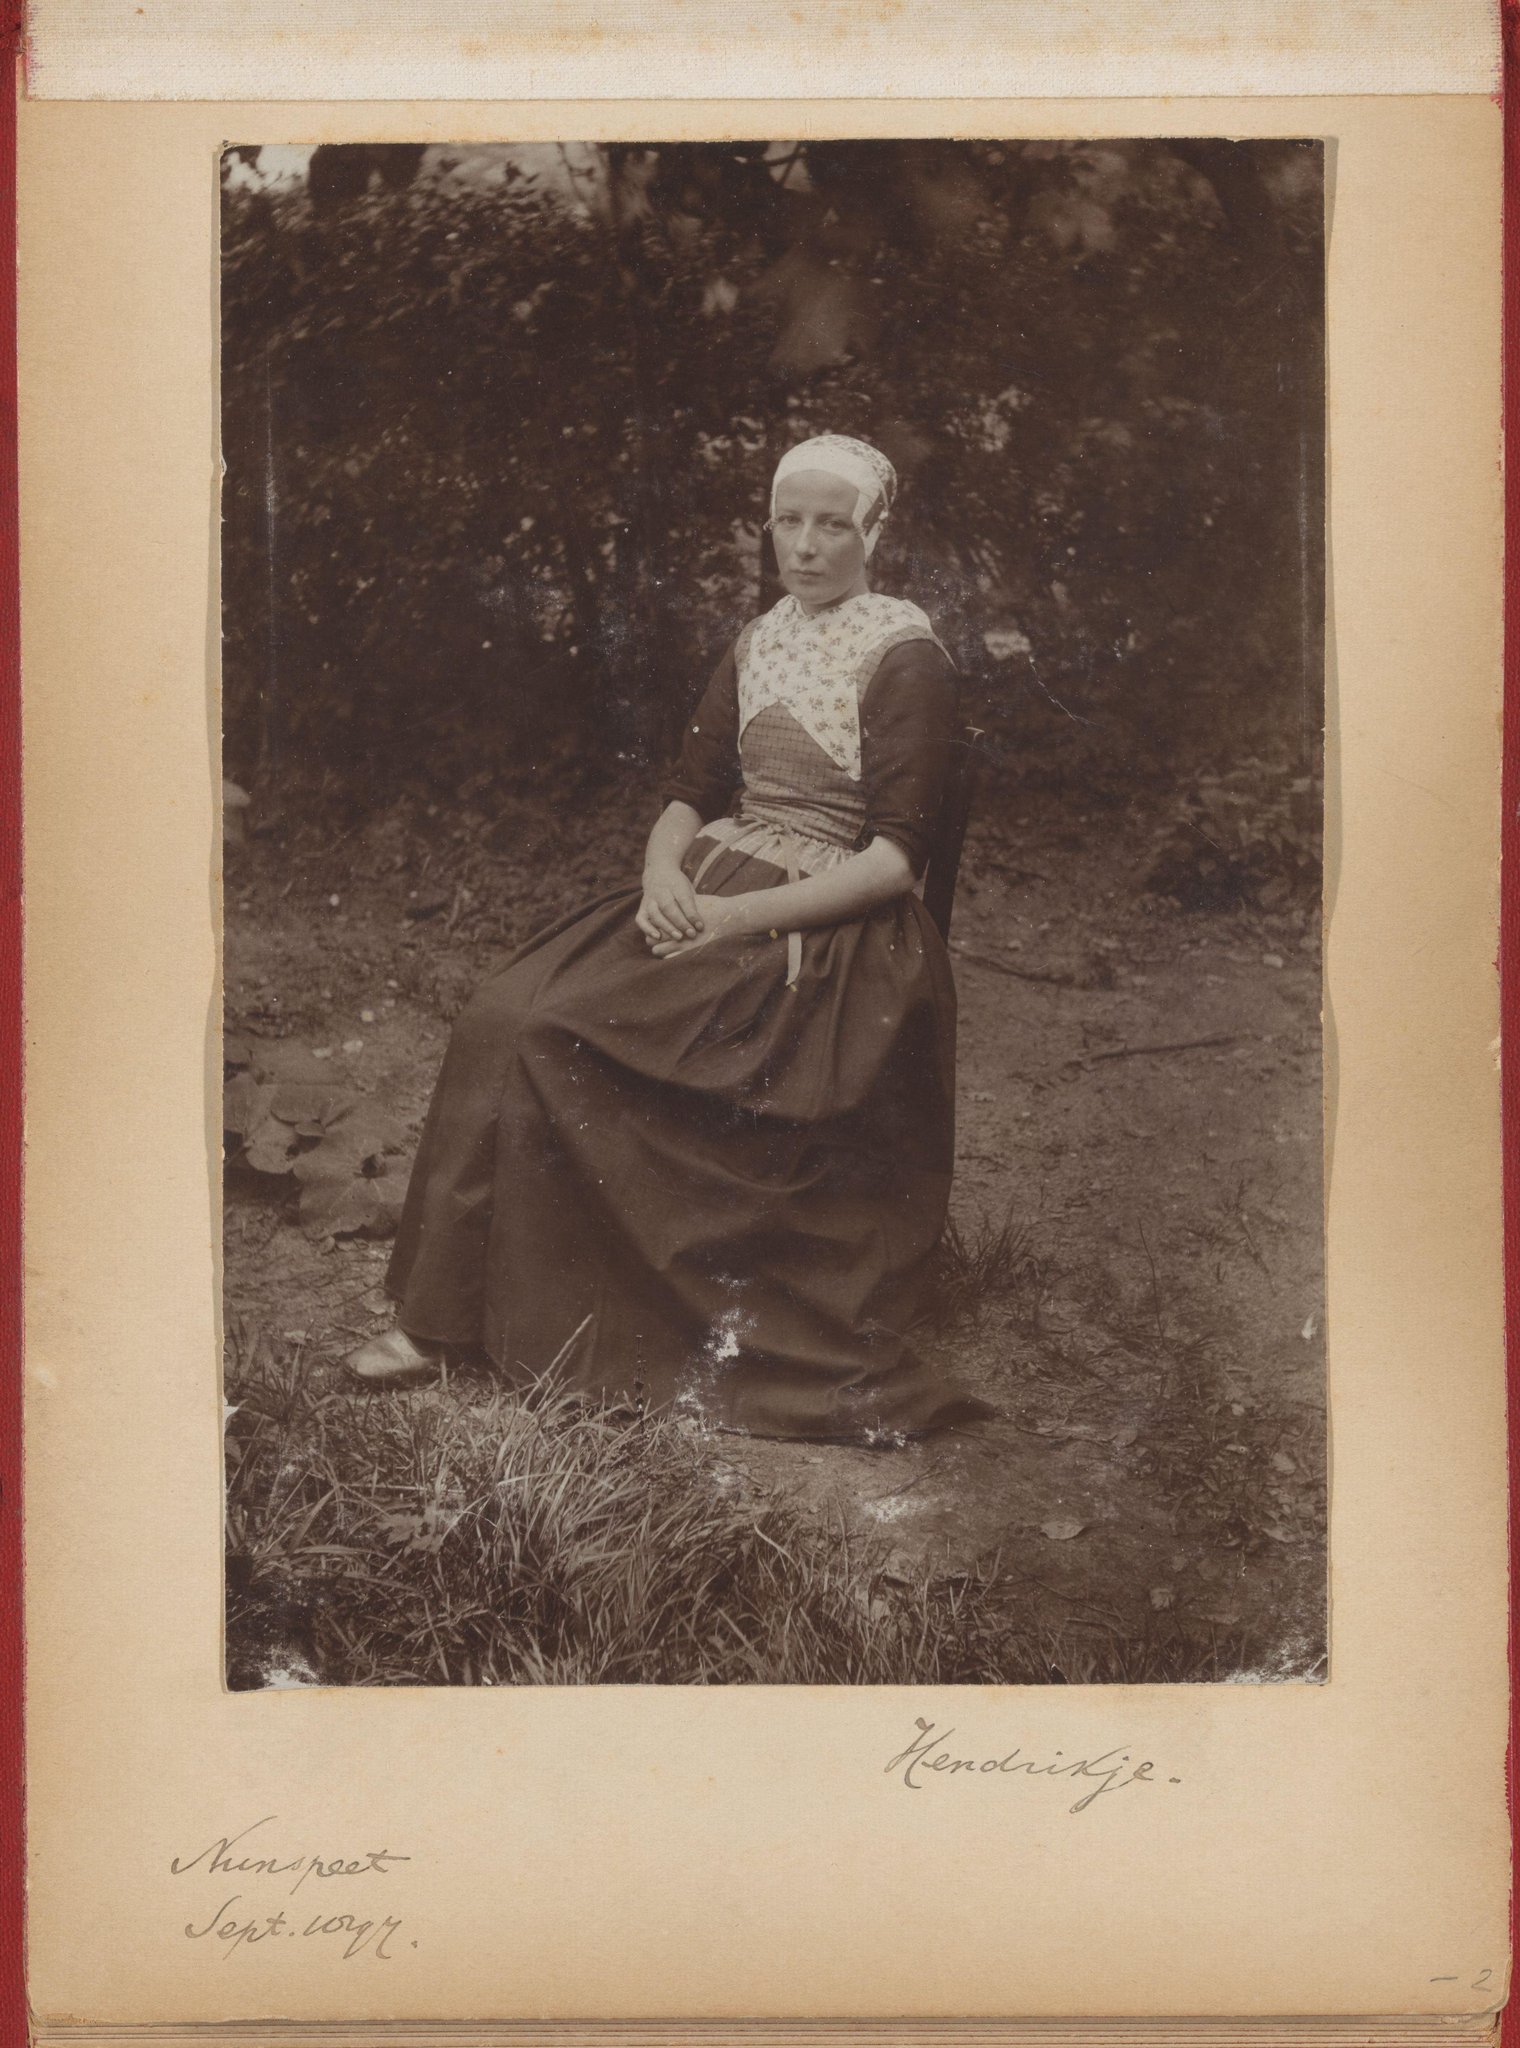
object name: photograph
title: Hendrikje Nunspeet sept. 1897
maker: gerard aalbersberg (us)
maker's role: amateurfotograaf, arts, chirurg, gynaecoloog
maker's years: 1870-1934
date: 1809-1897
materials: paper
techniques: gelatin silver print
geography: nunspeet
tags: nunspeet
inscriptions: title: ‘Hendrikje Nunspeet sept. 1897.’